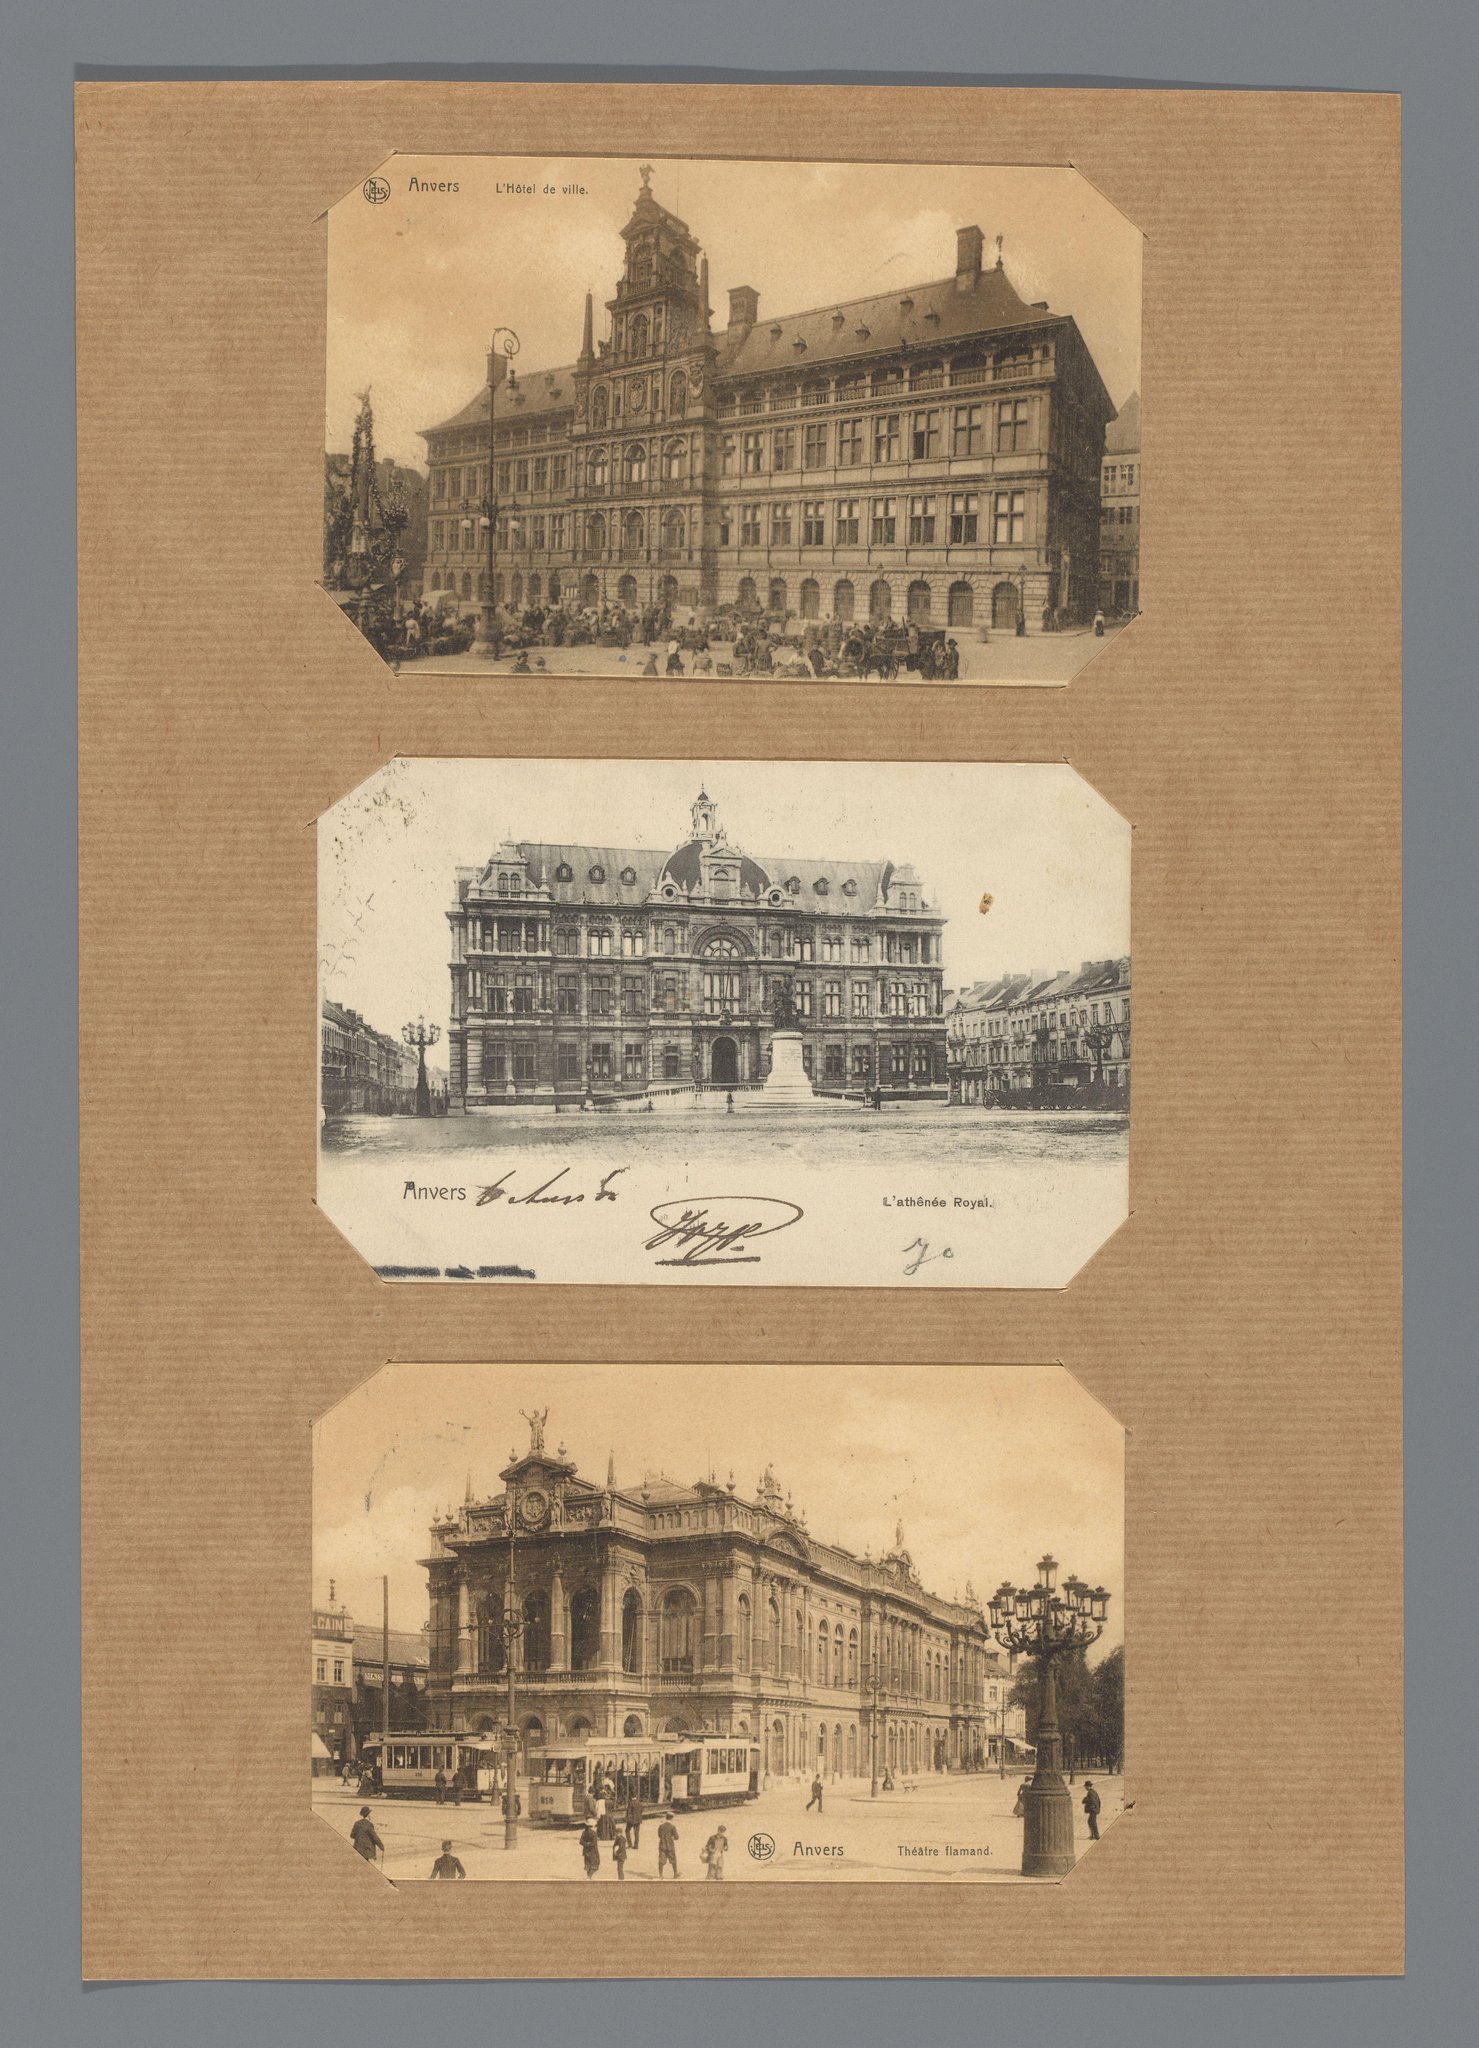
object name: photograph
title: Antwerpen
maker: Anonymous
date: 1860-1925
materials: photographic support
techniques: photograph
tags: antwerp